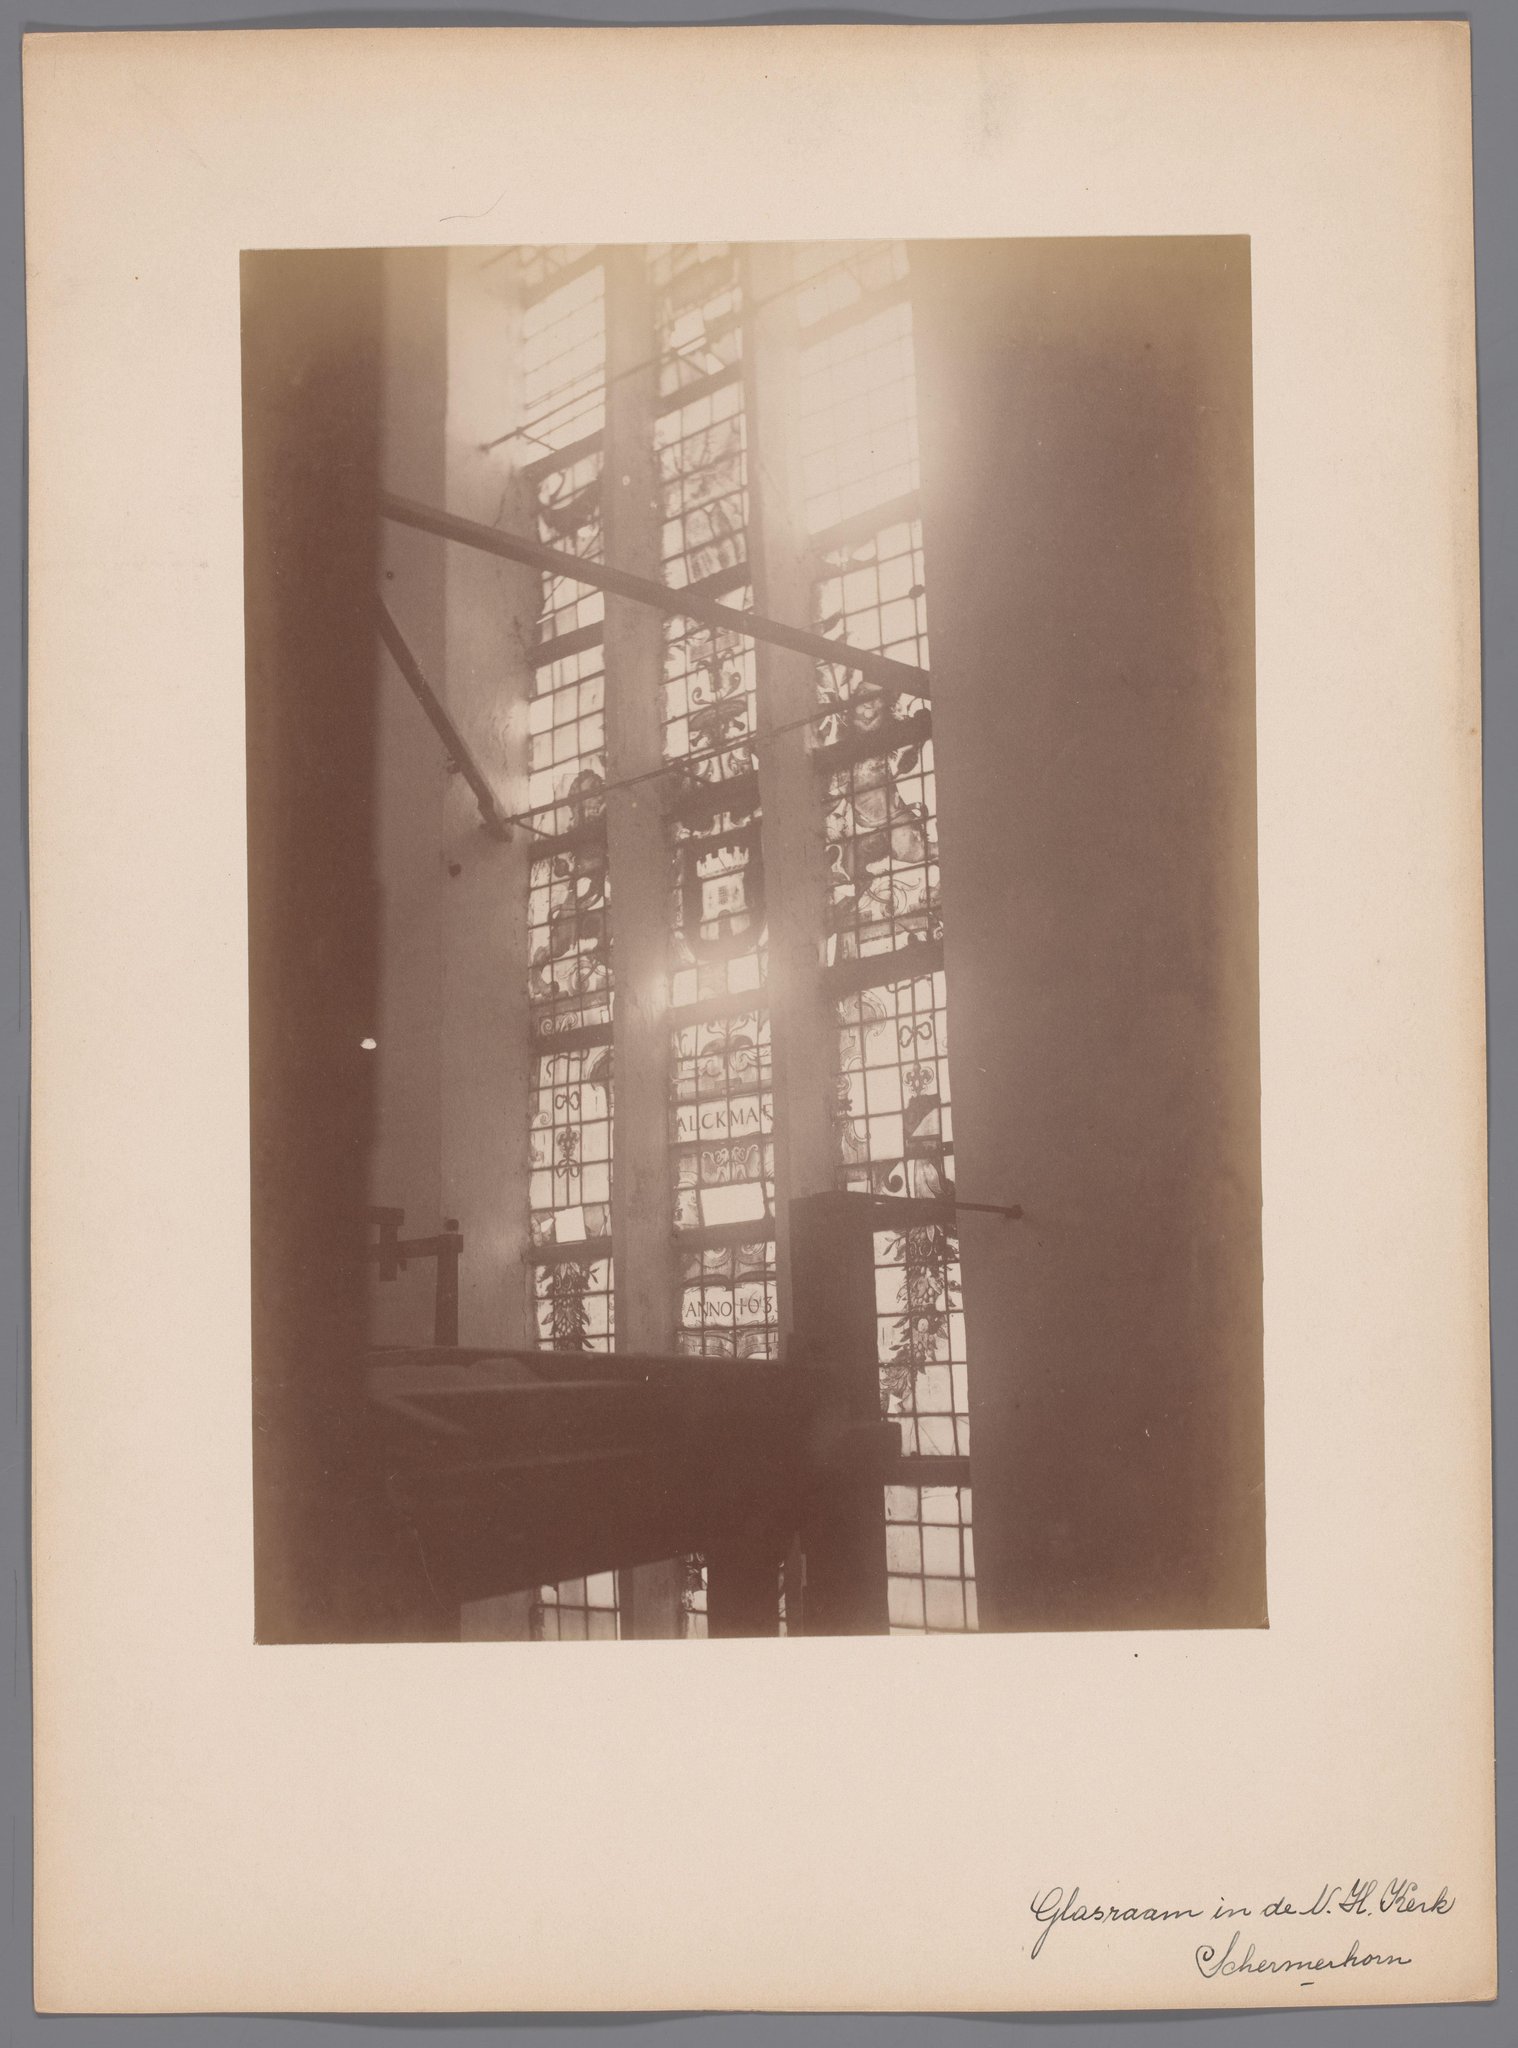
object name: photograph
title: Geschilderd raam in de Grote Kerk te Schermerhorn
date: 1890-1910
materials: cardboard, photographic support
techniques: albumen print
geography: schermerhorn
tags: church-window, e.g. rose-window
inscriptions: annotation: ‘Glasraam in de N.H. Kerk/ Schemerhorn’, annotation: ‘Schermerhorn/ glasraam in de Ned. Herv. Kerk’